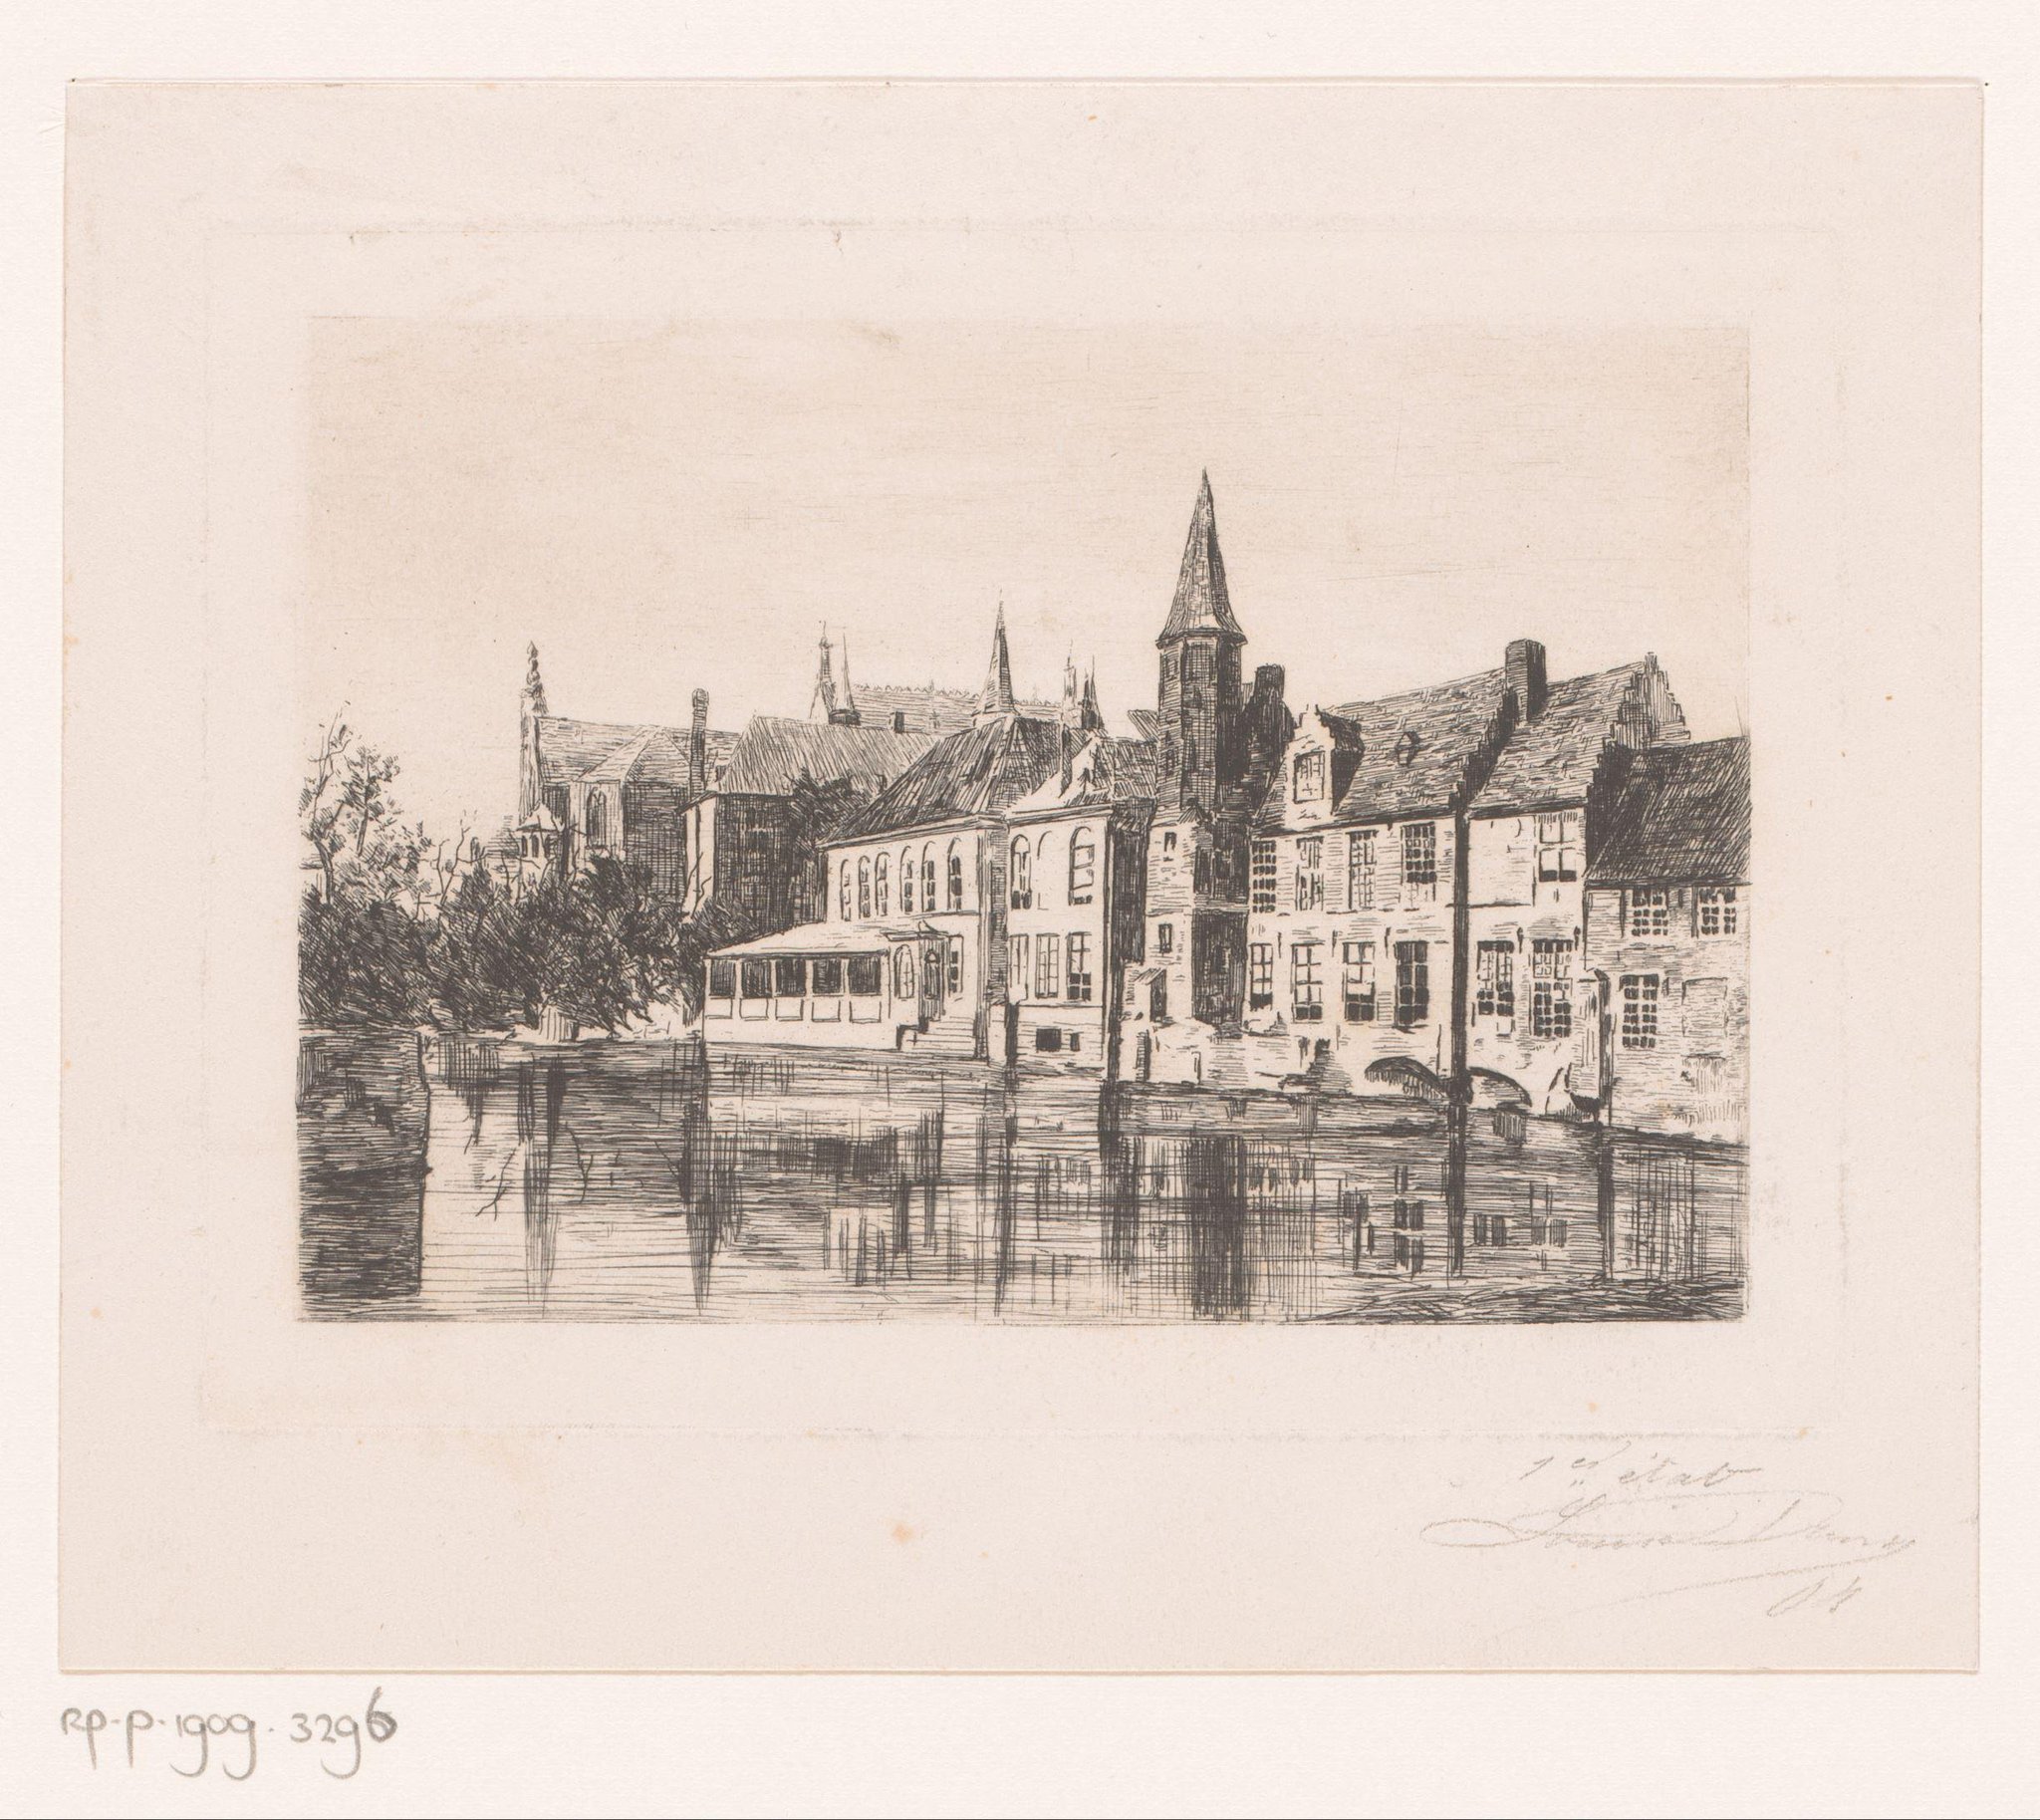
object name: print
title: Quai du Rosaire à Bruges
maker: louise danse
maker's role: painter, print maker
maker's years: 1867-1948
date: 1880-1889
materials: paper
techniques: etching, intaglio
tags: canals, waters (in city), bruges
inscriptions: annotation: ‘1er état’, collector's mark: Lugt 2228